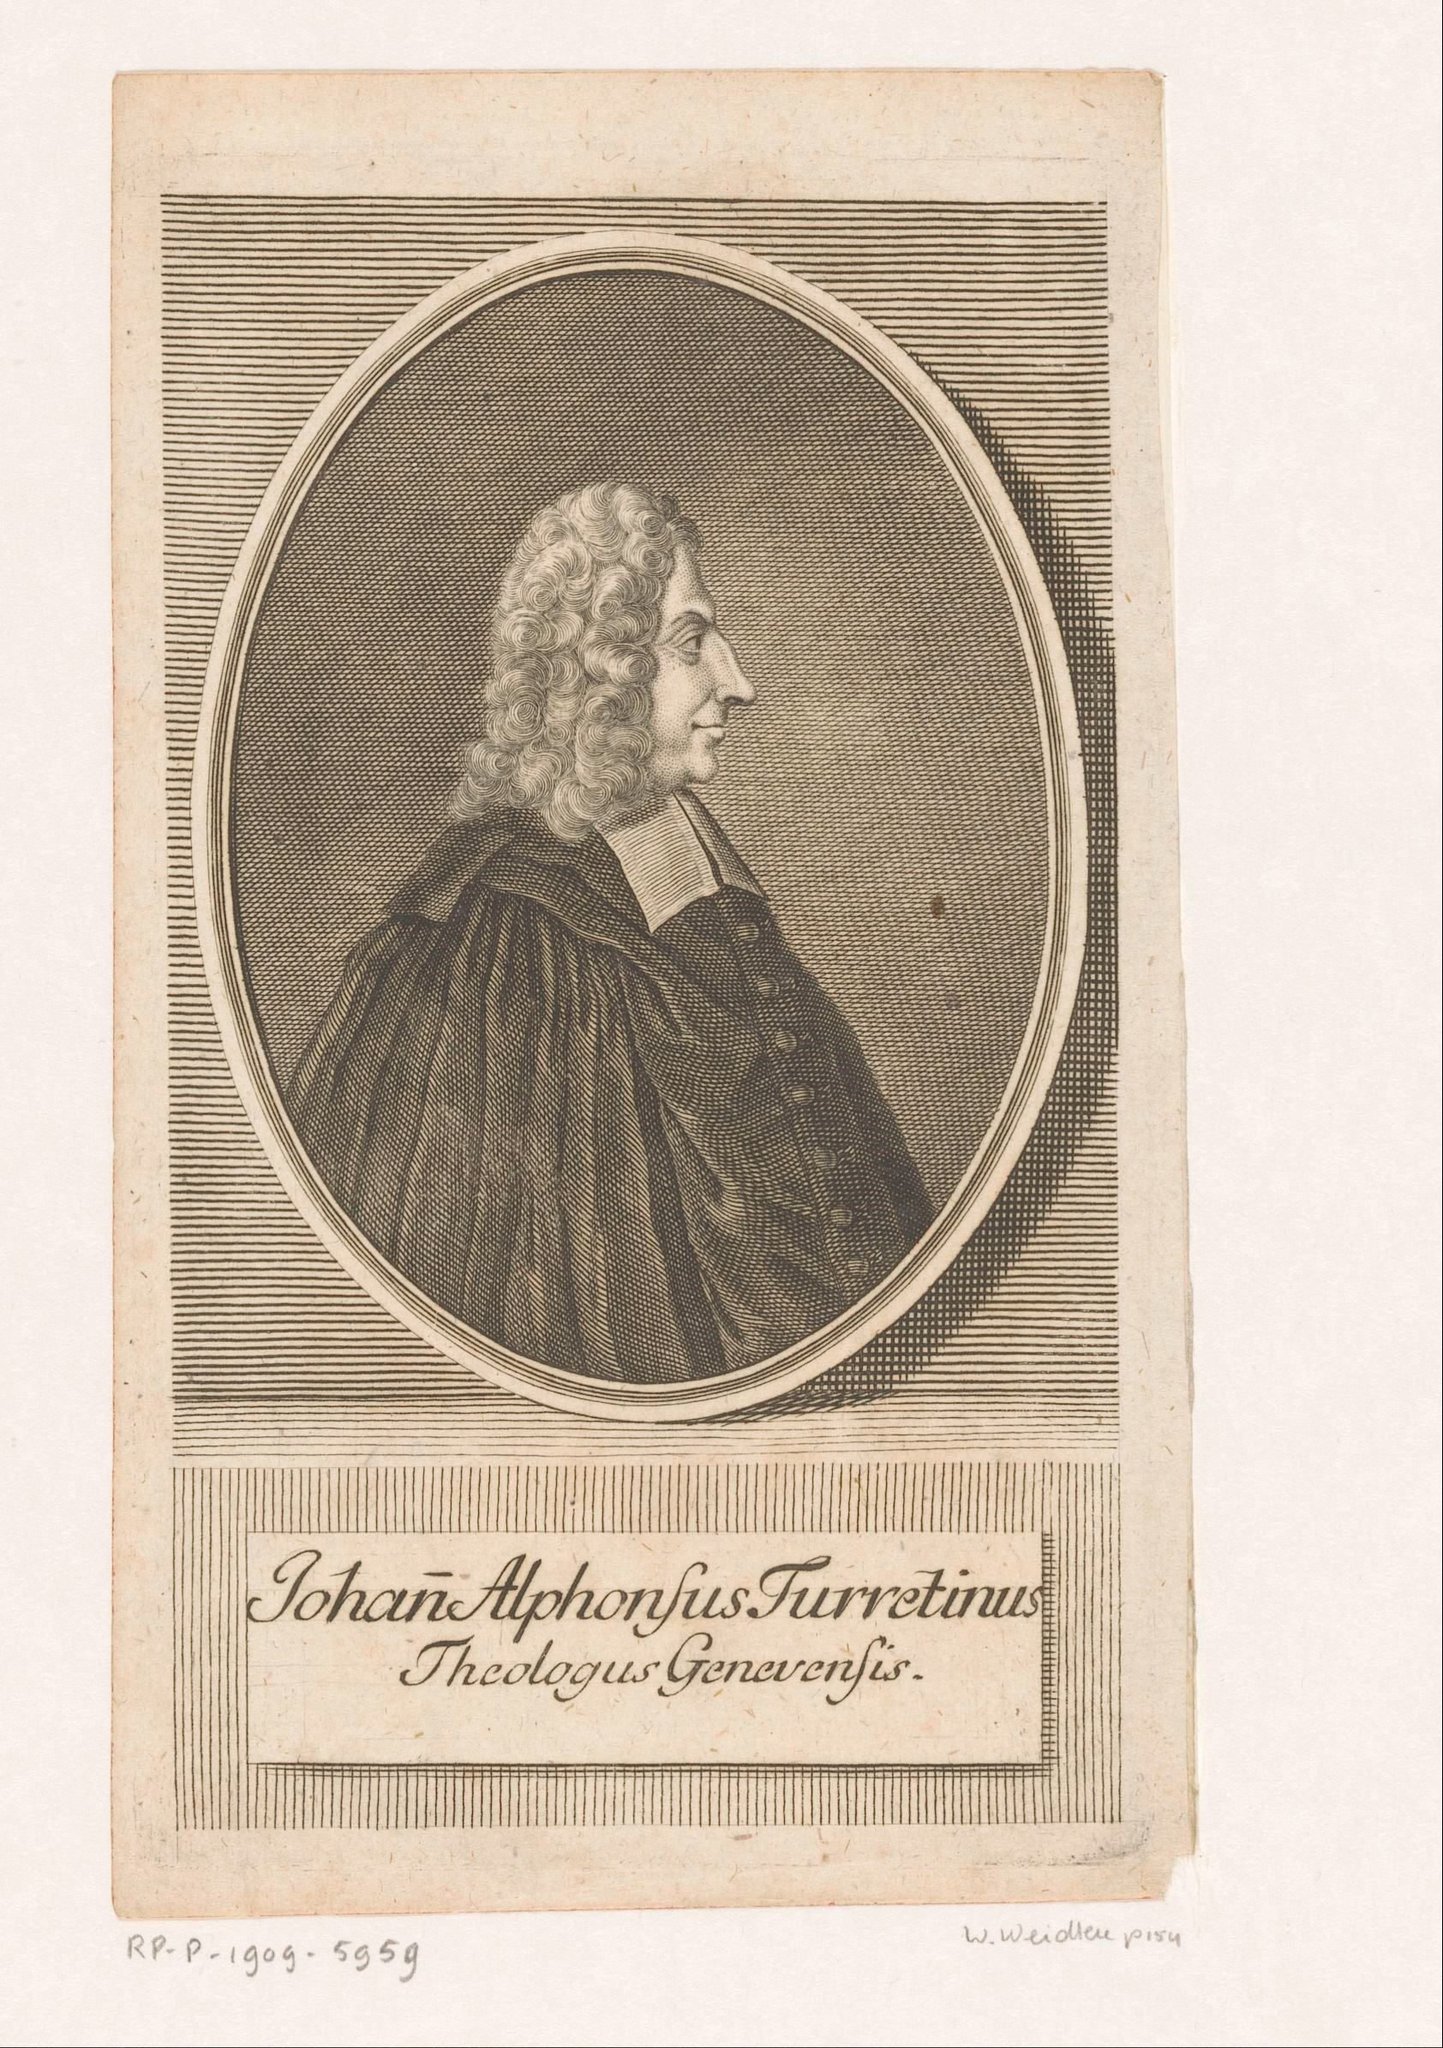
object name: print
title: Portret van Jean-Alphonse Turrettini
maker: johann martin bernigeroth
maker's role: print maker, publisher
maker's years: 1713-1767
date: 1739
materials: paper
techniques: engraving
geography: leipzig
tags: historical persons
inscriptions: collector's mark: Lugt 2228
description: Prent ook gebruikt in: Deutsche Acta Eruditorum (...). Leipzig: Johann Gottlieb Gleditsch, 1739.